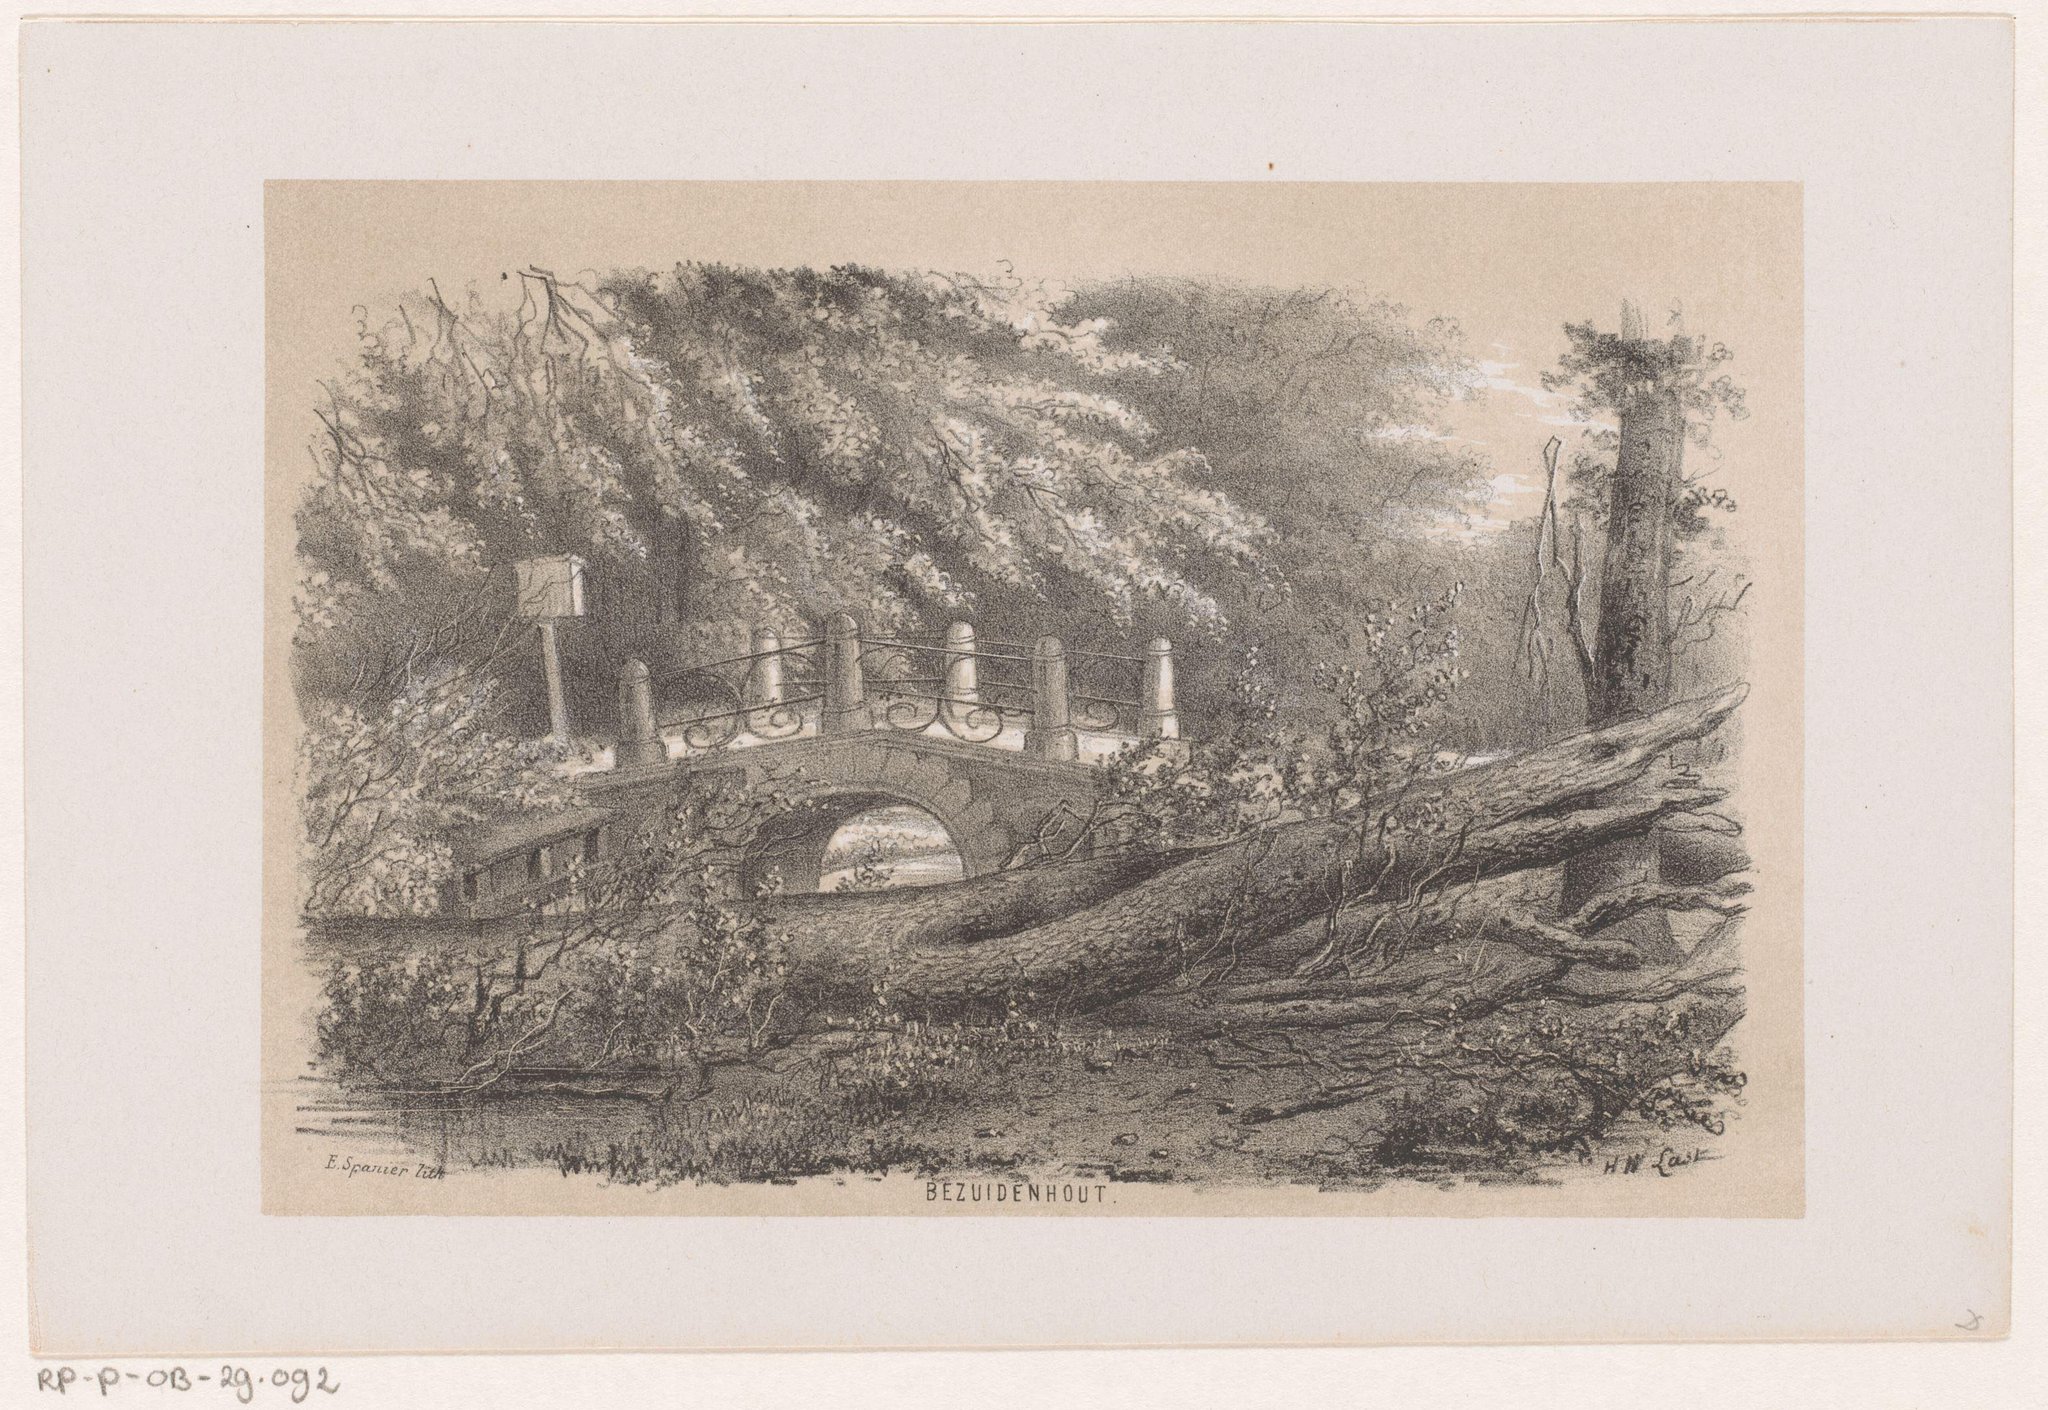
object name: print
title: Bezuidenhout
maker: m.m. couvée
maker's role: publisher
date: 1860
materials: paper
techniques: tone lithography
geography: the hague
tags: storm on land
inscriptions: collector's mark: Lugt 2228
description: Een omgewaaide boom bij een brug in Bezuidenhout, na de storm. Onderdeel van het album met tien losse steendrukken met voorstellingen van de schade aangericht door de 'Pinksterstorm' van 28 mei 1860 in het Haagse Bos en omgeving.